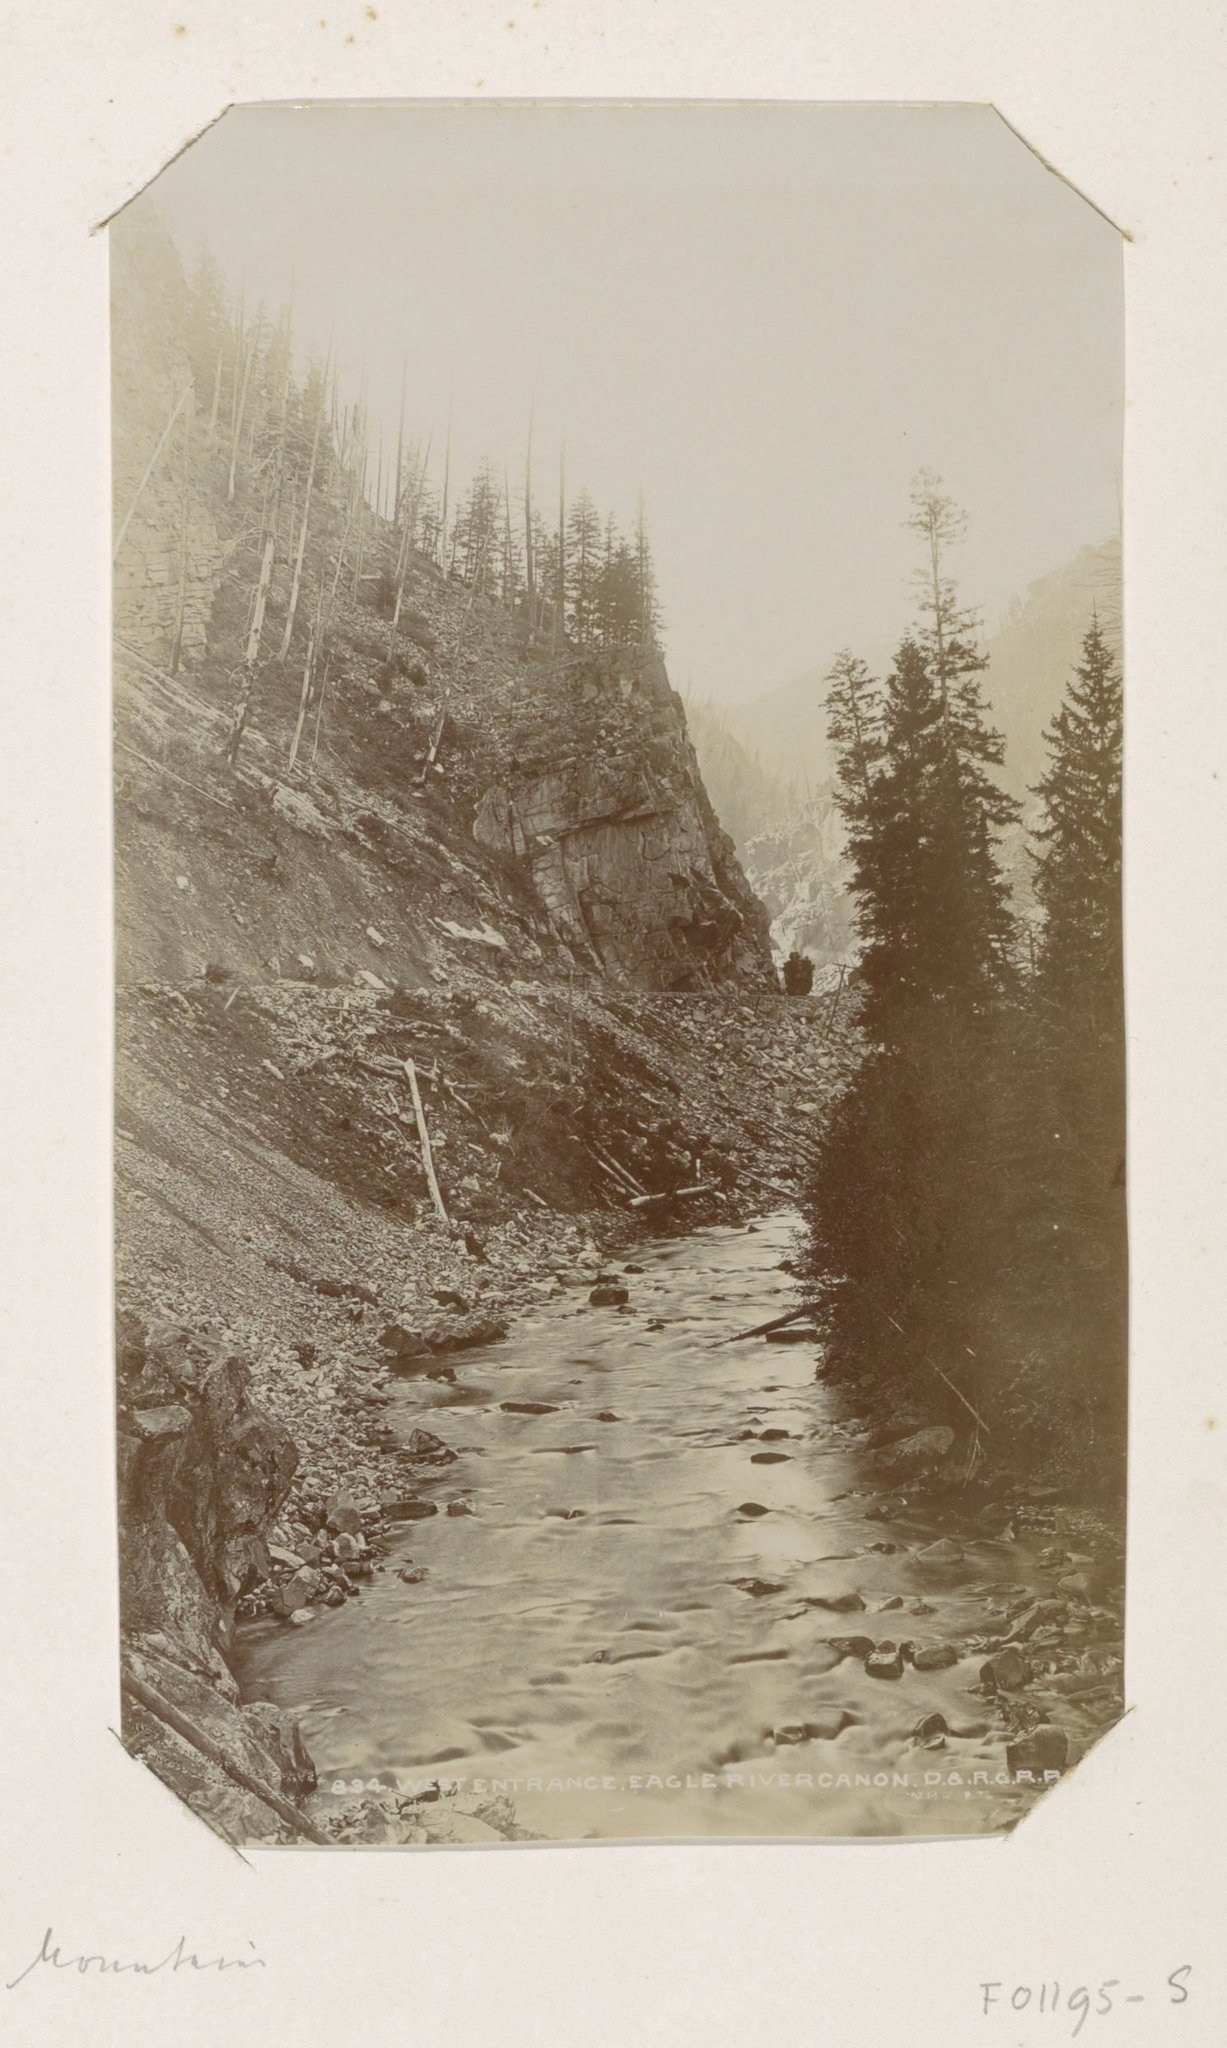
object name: photograph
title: West Entrance, Eagle River Canon. D. and R.G.R.R.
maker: william henry jackson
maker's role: fotograaf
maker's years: 1843-1942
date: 1860-1900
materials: cardboard, paper, photographic support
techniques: gelatin silver print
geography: colorado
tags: ravine, chasm, abyss, canyon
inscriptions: negative number: ‘834’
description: Onderdeel van Fotoalbum van een reis door de Verenigde Staten, Honolulu, Nederlands-Indië, Aden, Zanzibar en Zuidelijk Afrika.